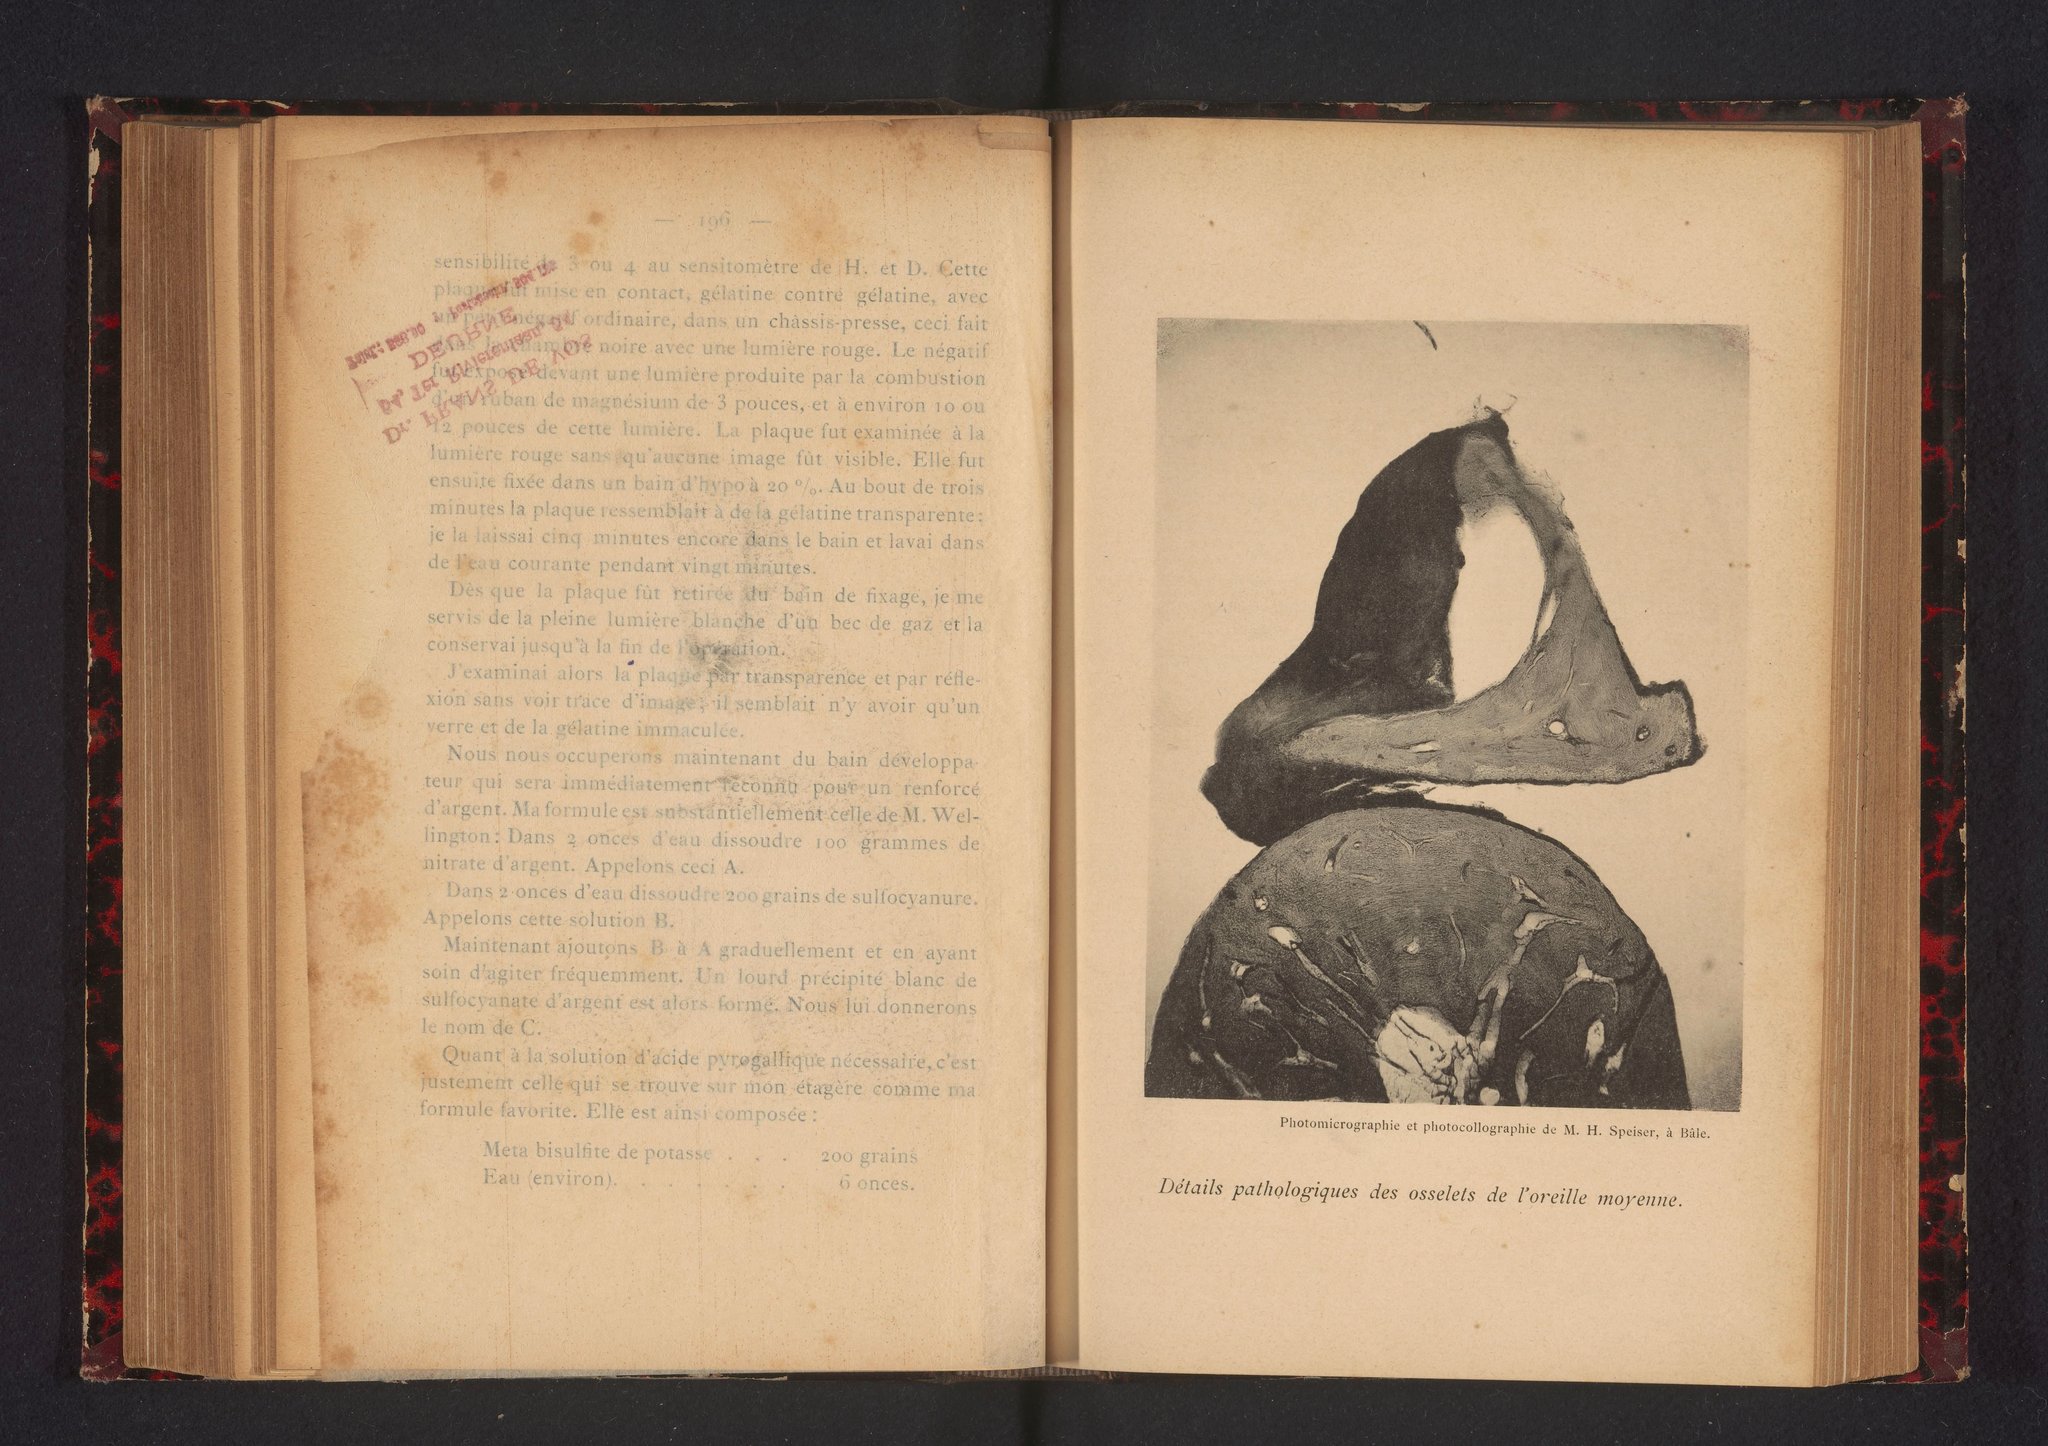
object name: photomechanical print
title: Détails pathologiques des osselets de l'oreille moyenne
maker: hans speiser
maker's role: fotograaf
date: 1893-1898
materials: paper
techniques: photograph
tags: ears